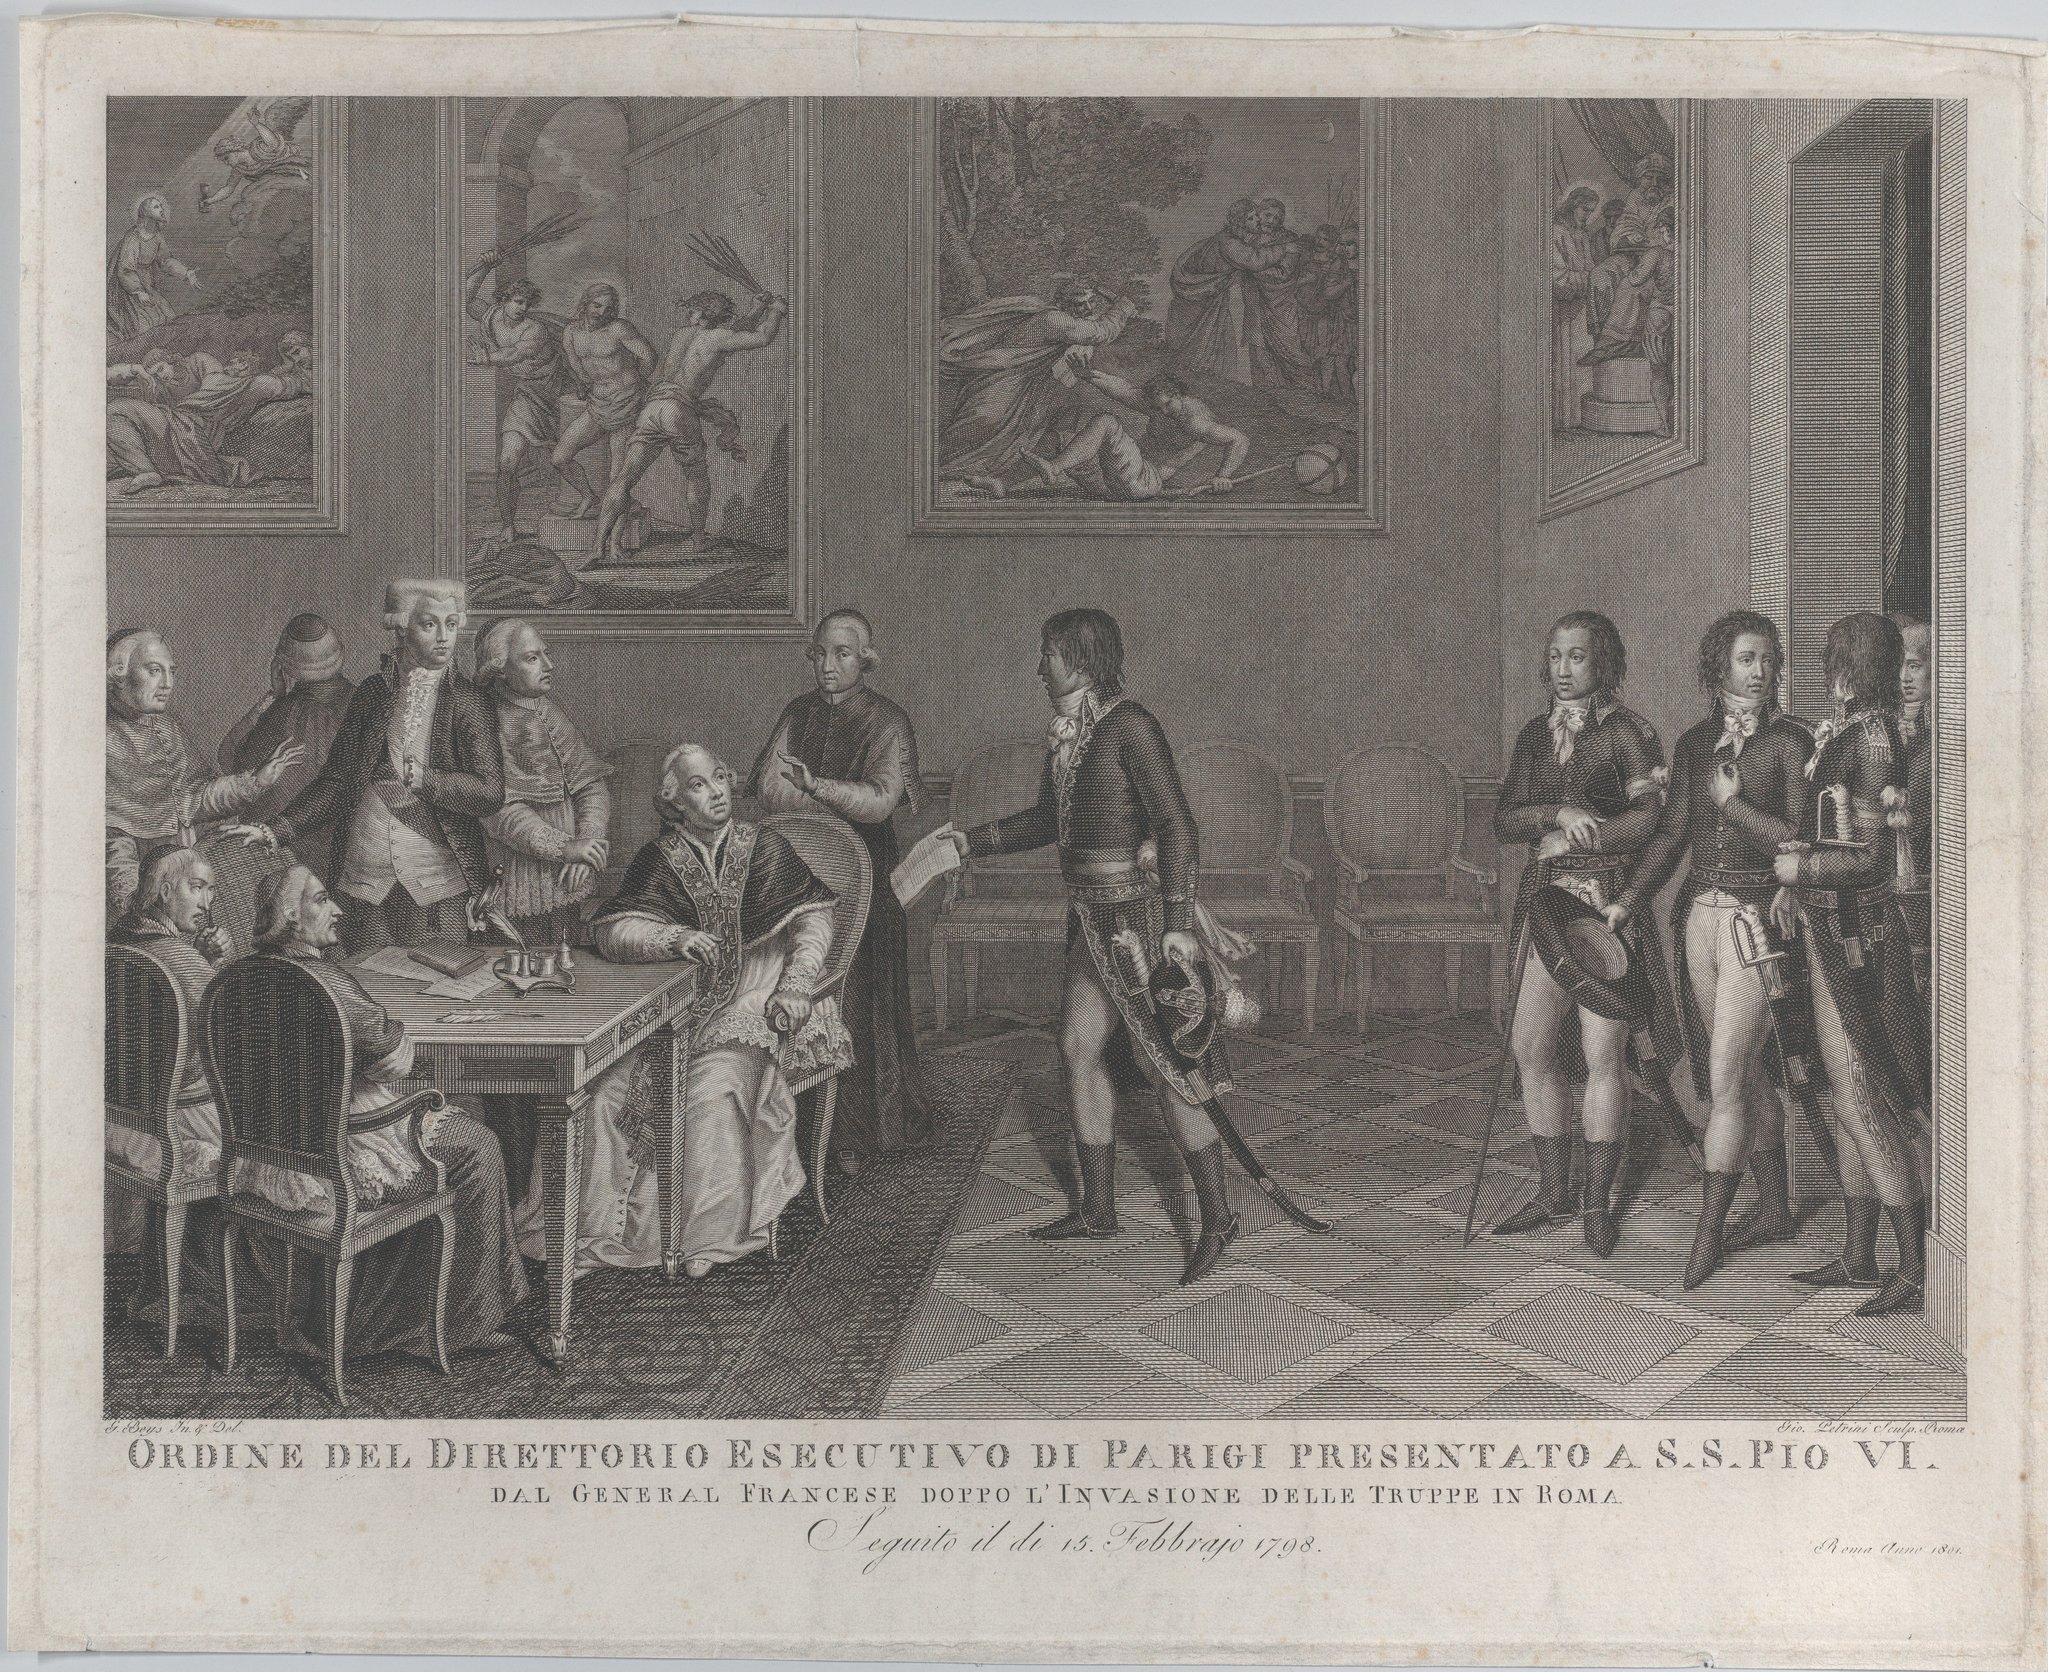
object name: print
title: French general handing Directory order to Pope Pius VI after invasion of Rome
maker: giovanni petrini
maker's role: artist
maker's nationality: italian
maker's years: 1750-1850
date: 1801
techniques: engraving